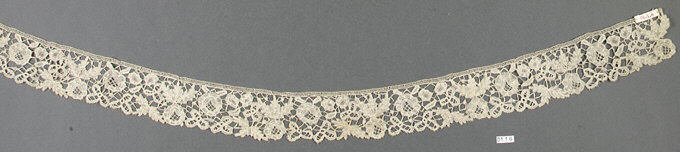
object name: fragment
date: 1801-1900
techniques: lace